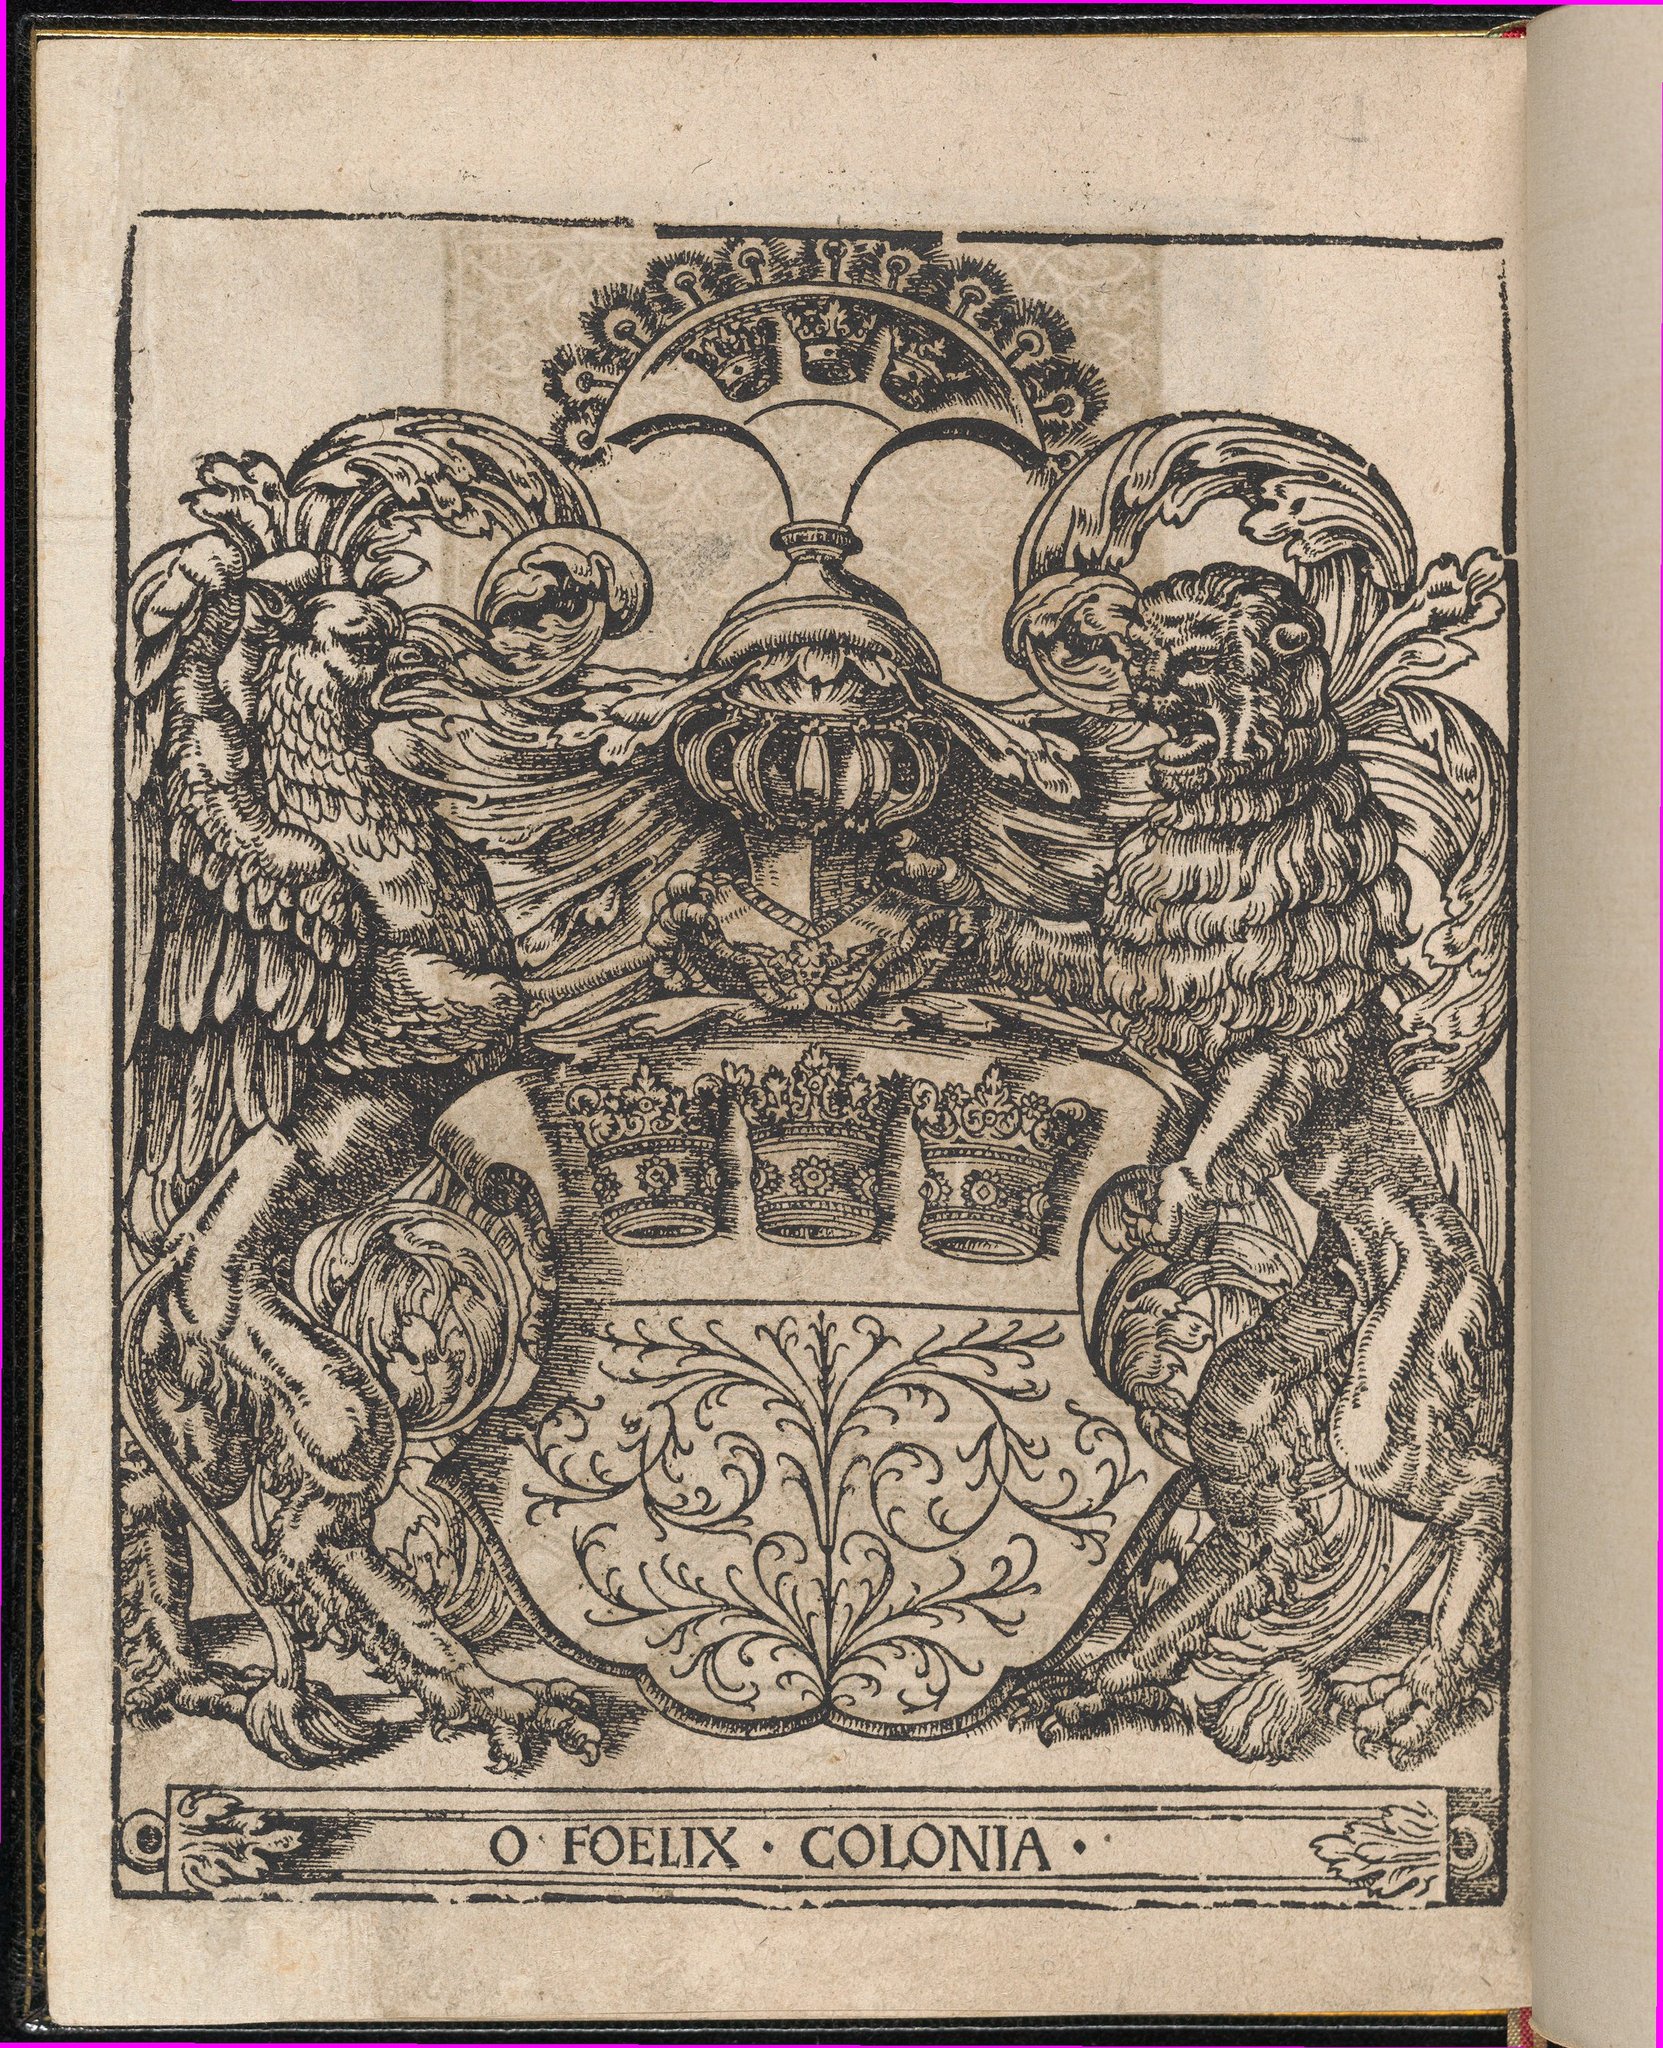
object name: book print ornament architecture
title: Page from Ein new kunstlich Modelbuch...(Page 51v)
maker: peter quentel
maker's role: publisher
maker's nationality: german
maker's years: 1500-1550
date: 1544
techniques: woodcut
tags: coat of arms